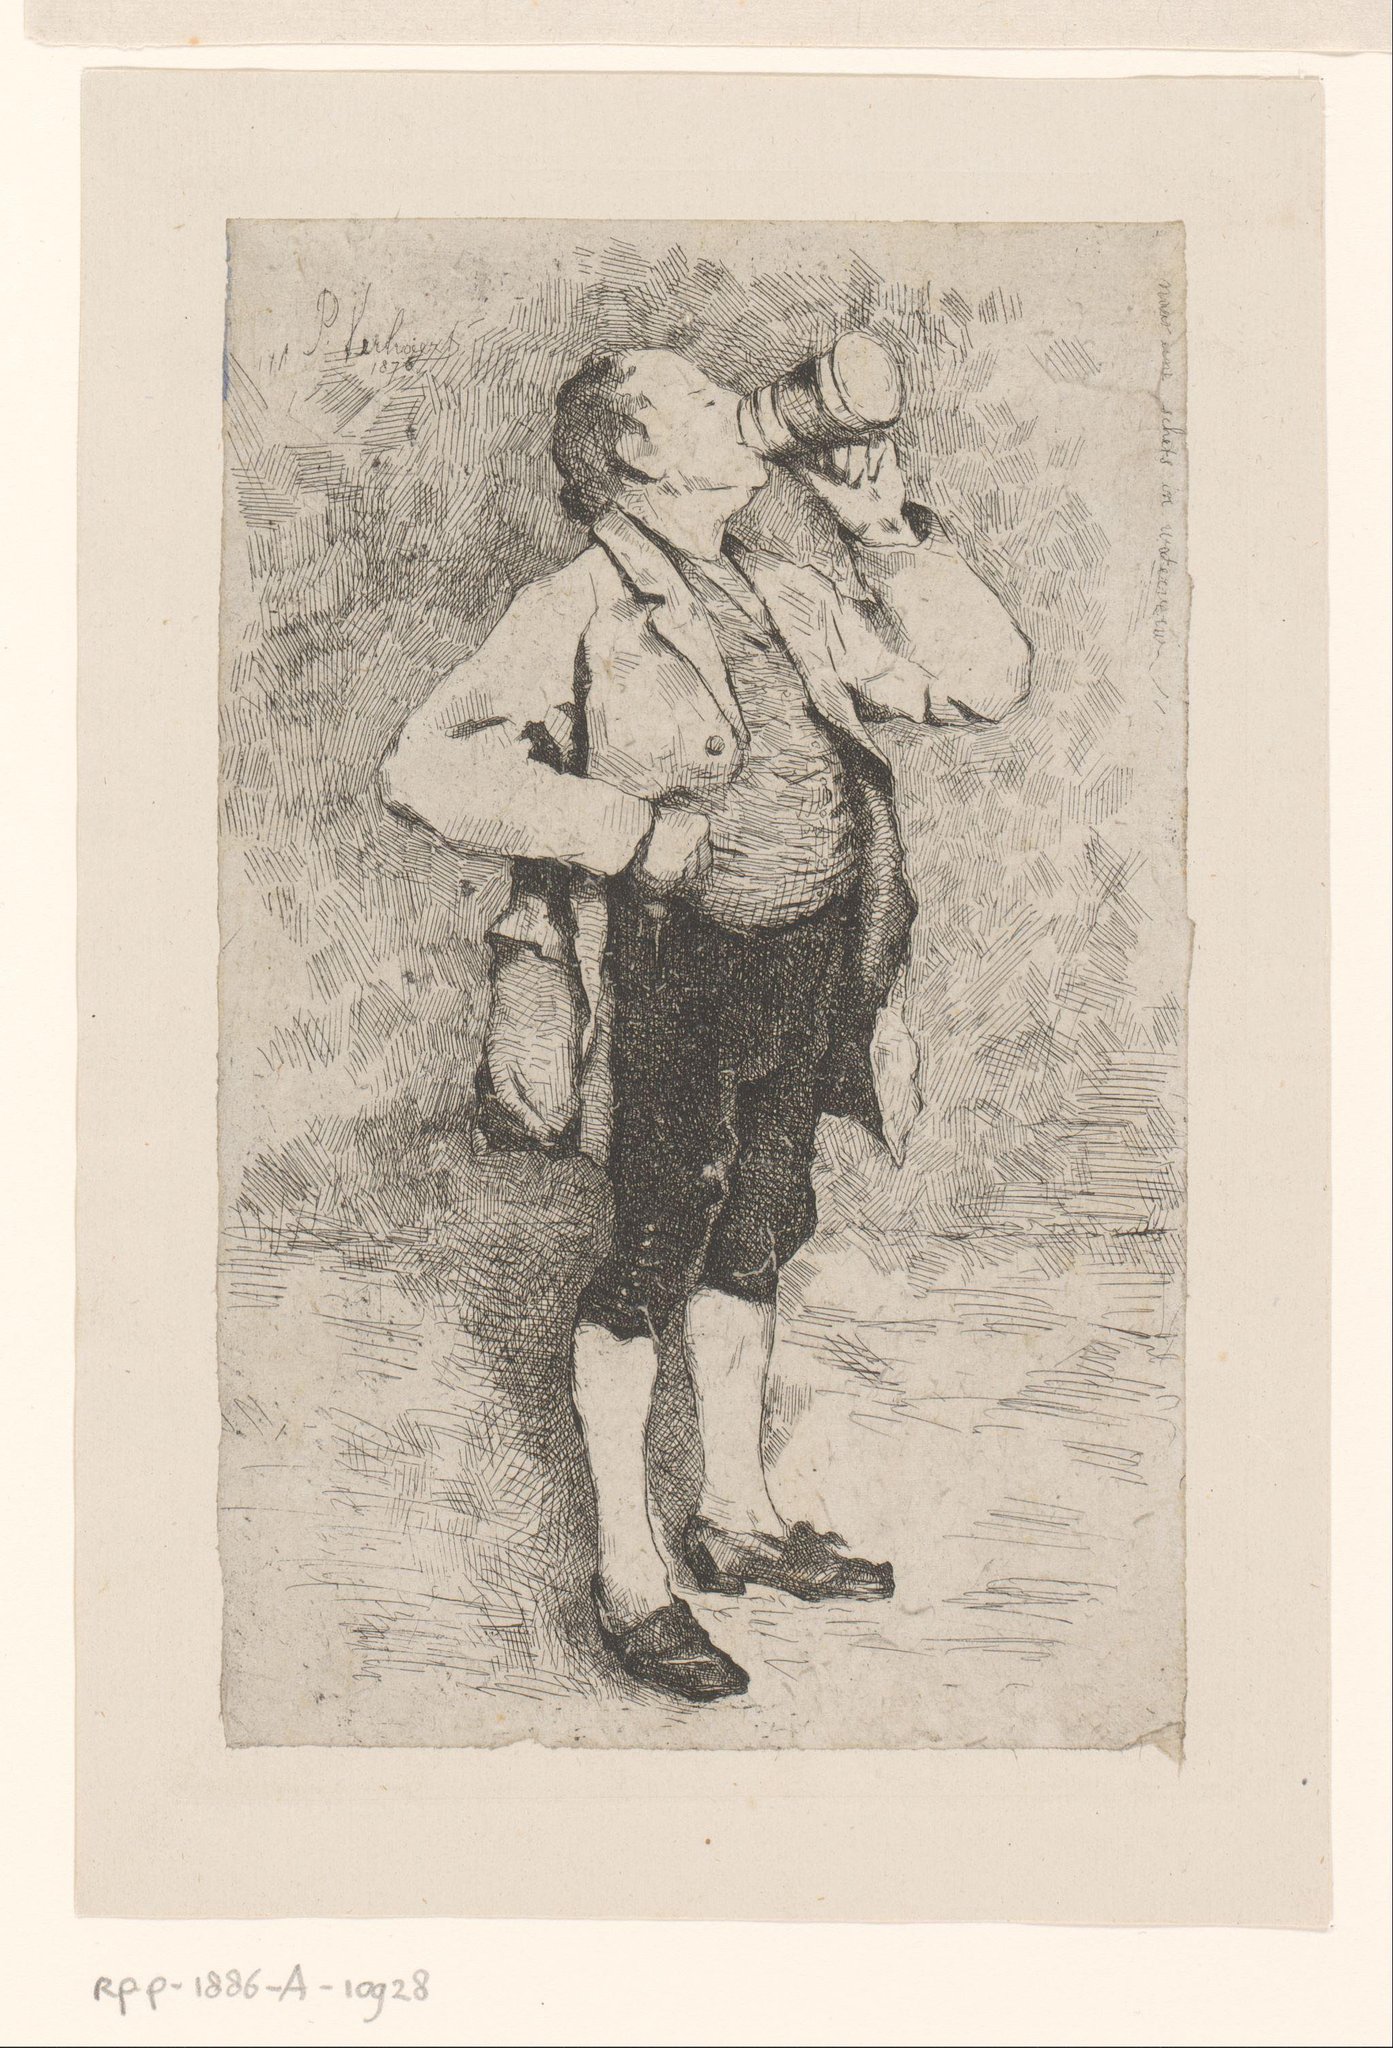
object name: print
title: Drinkende man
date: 1876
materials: paper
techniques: etching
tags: adult man, drinking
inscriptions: collector's mark: Lugt 2228